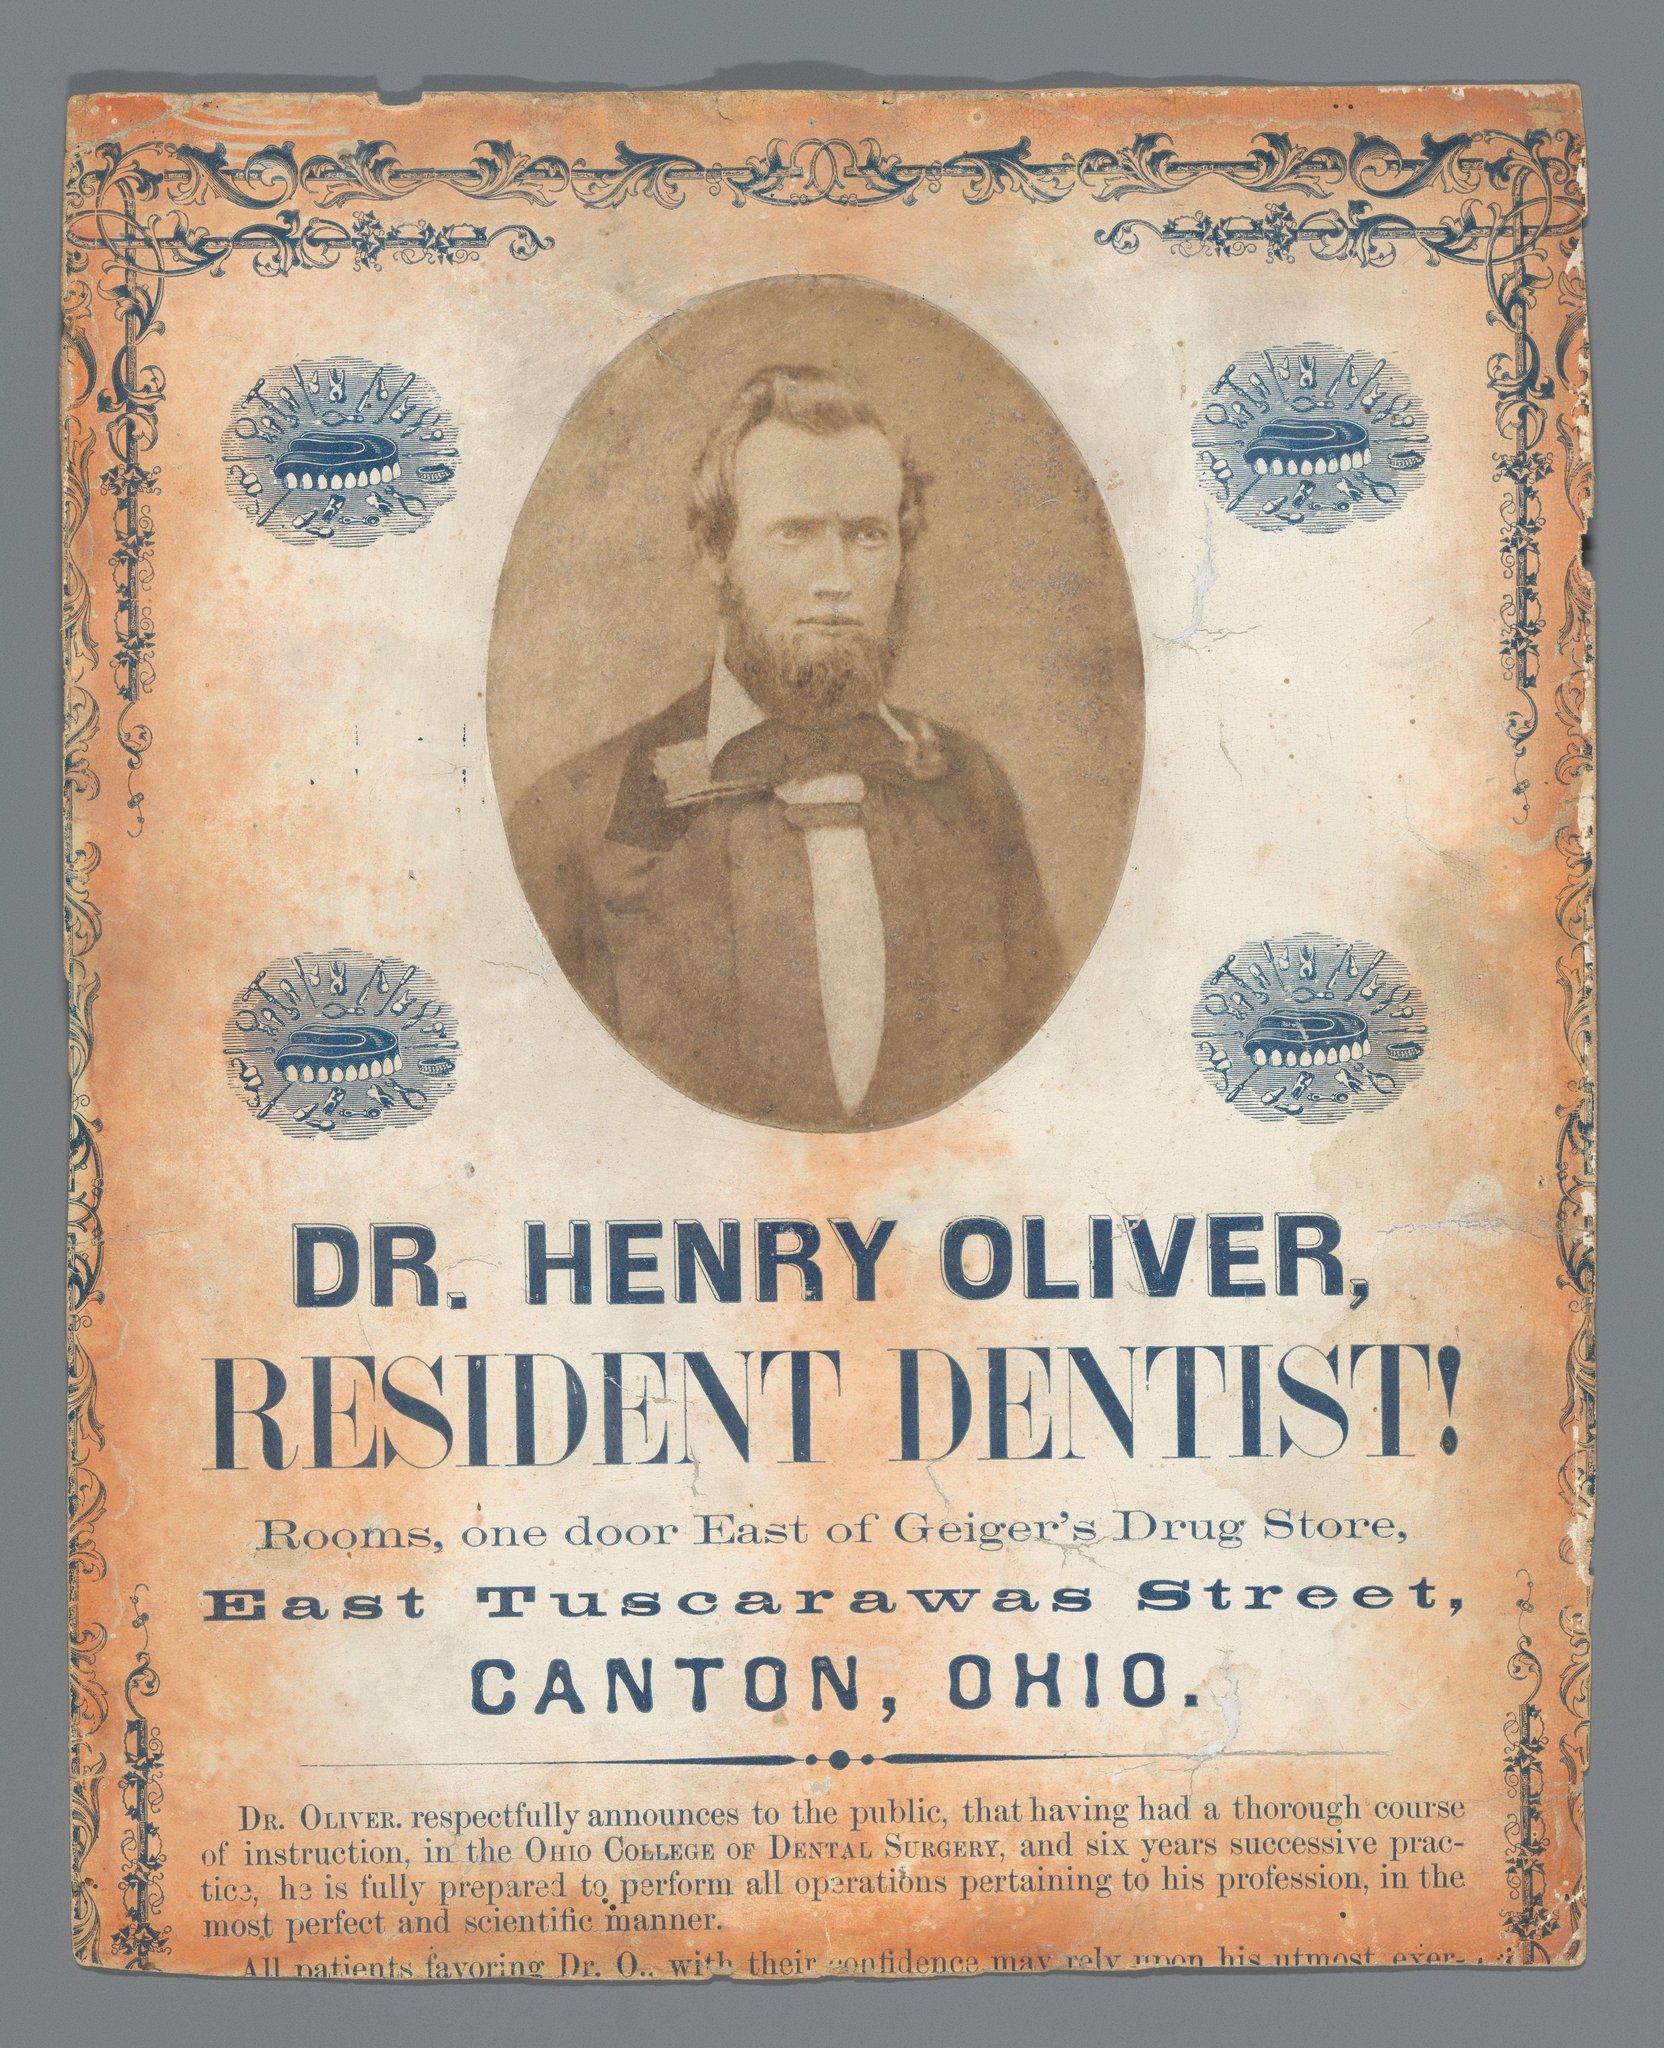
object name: photograph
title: Portret van Henry Oliver met reclame voor zijn tandartsenpraktijk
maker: Anonymous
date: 1850-1900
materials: paint, paper, photographic support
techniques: albumen print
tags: historical persons, (barber as) dentist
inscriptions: inscription: ‘DR. HENRY OLIVER/ RESIDENT DENTIST!/ Rooms, one door East of Geiger's Drug Strore,/ East Tuscarawas Street, CANTON, OHIO./ (...)’, number: ‘H5271’